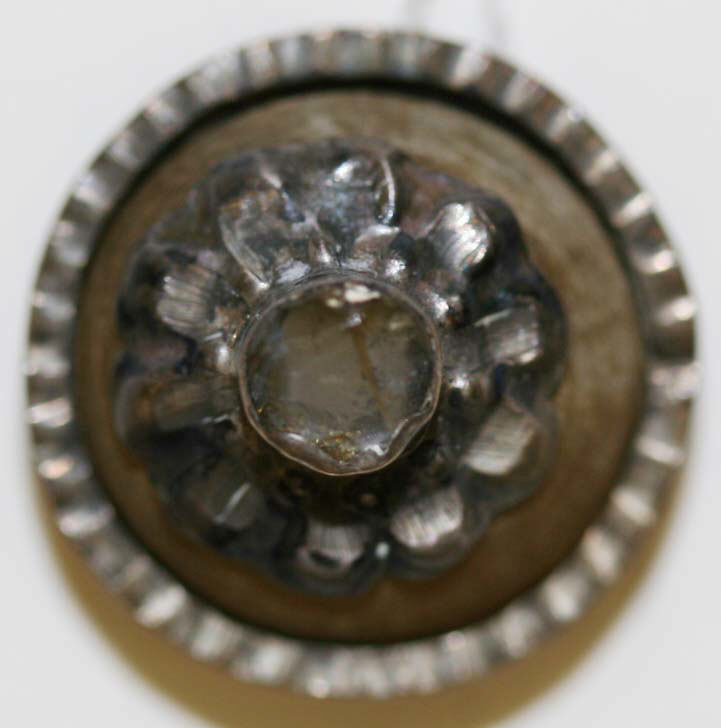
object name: button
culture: american or european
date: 1601-1700